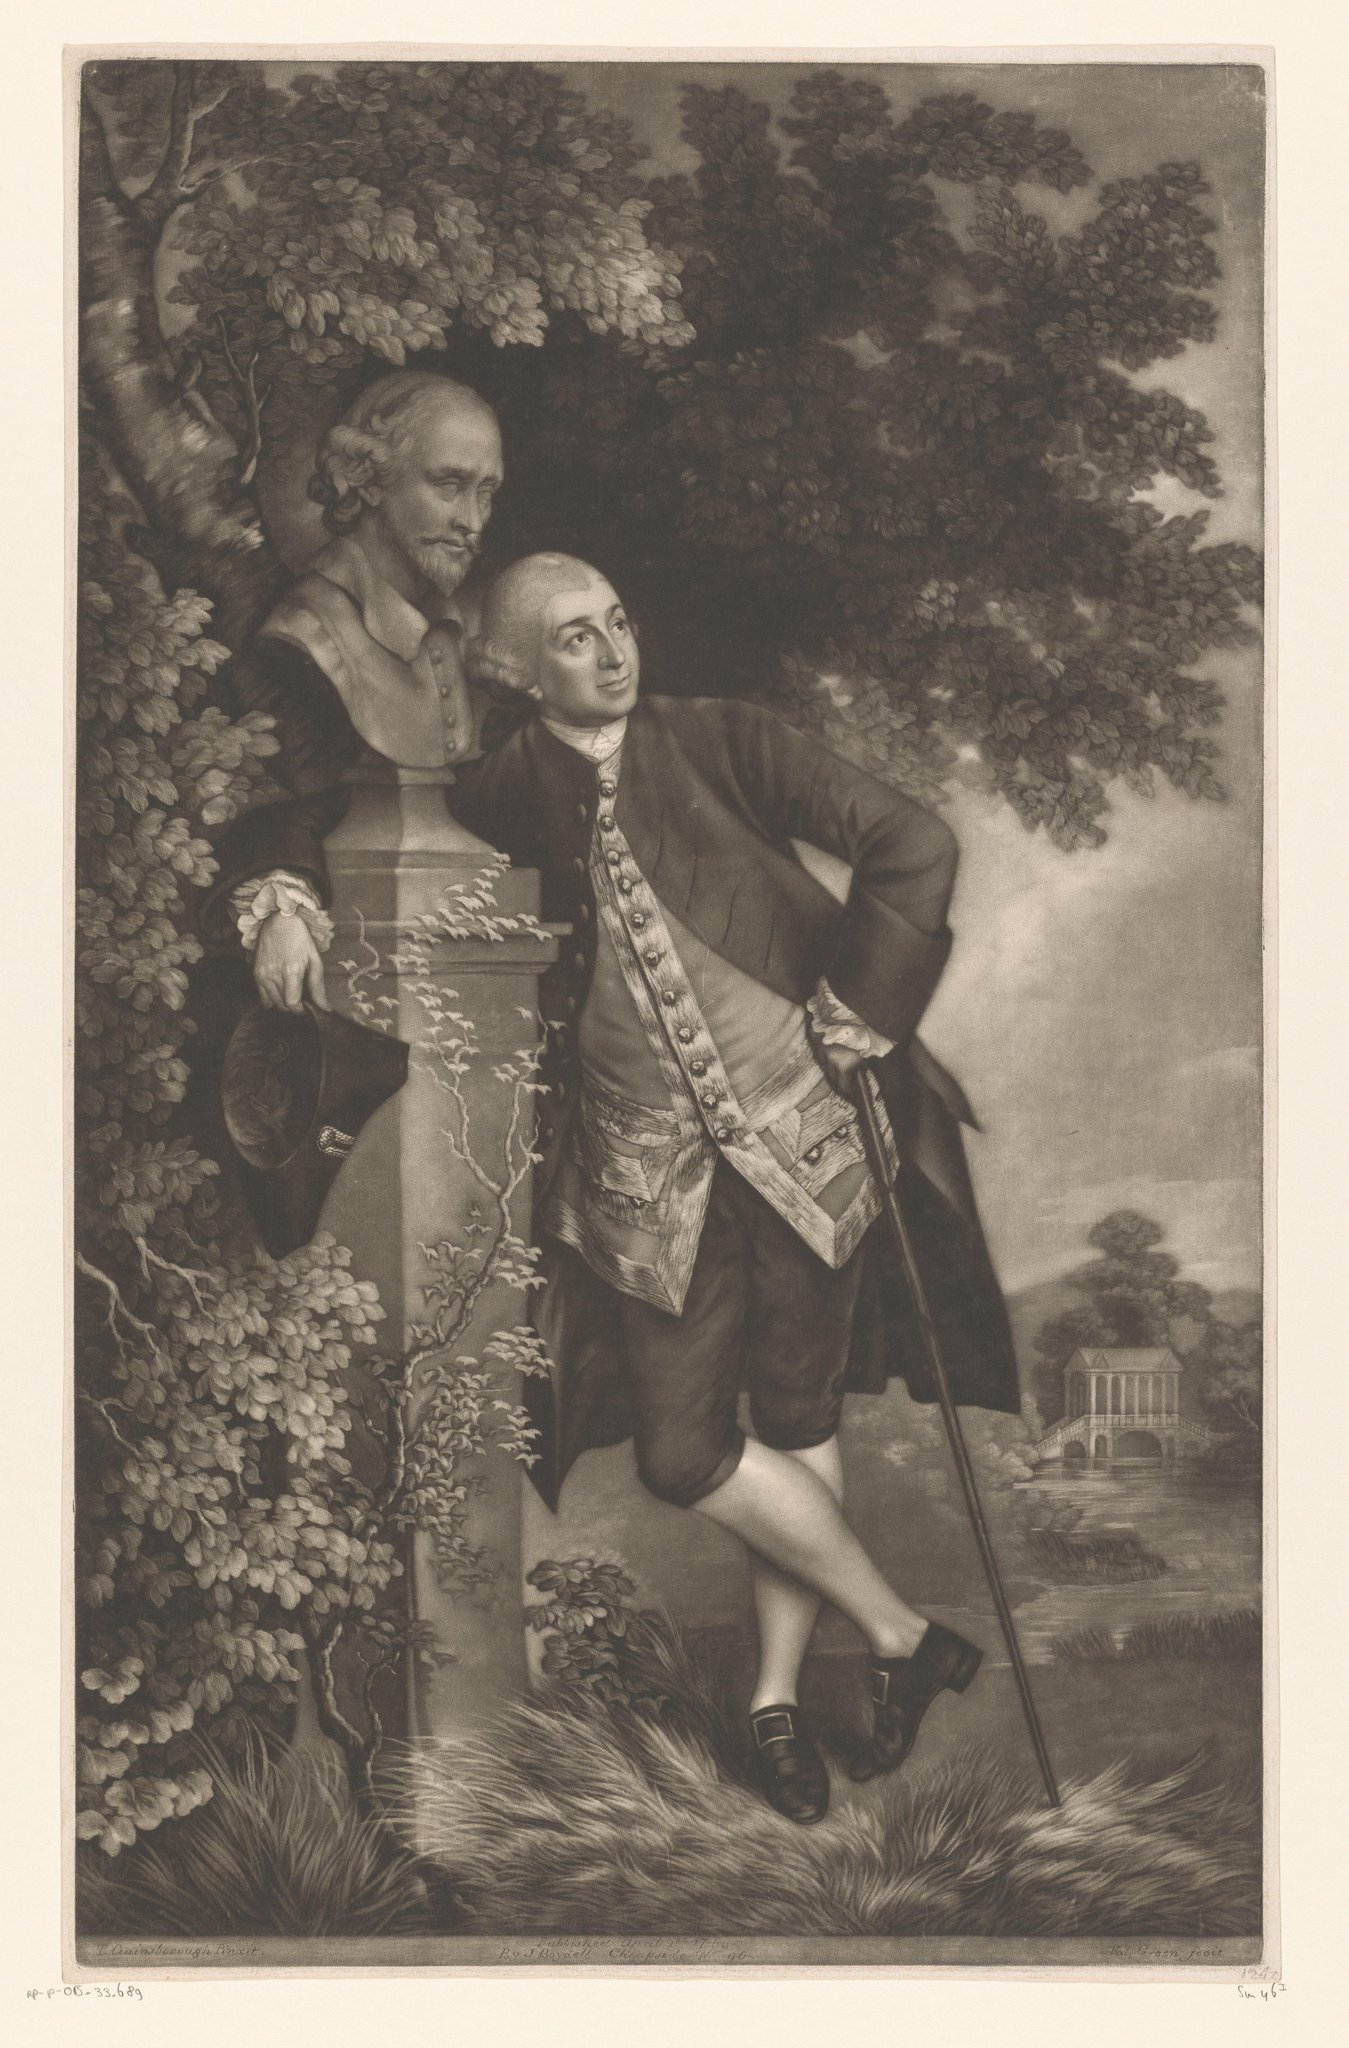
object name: print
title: Portret van David Garrick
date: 1704-1769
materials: paper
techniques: mezzotint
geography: london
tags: london, david garrick, english or landscape garden, historical persons, portrait of actor, actress, walking-stick, staff, cane (+ men's clothes), statues, sculptures in garden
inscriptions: collector's mark: Lugt 240